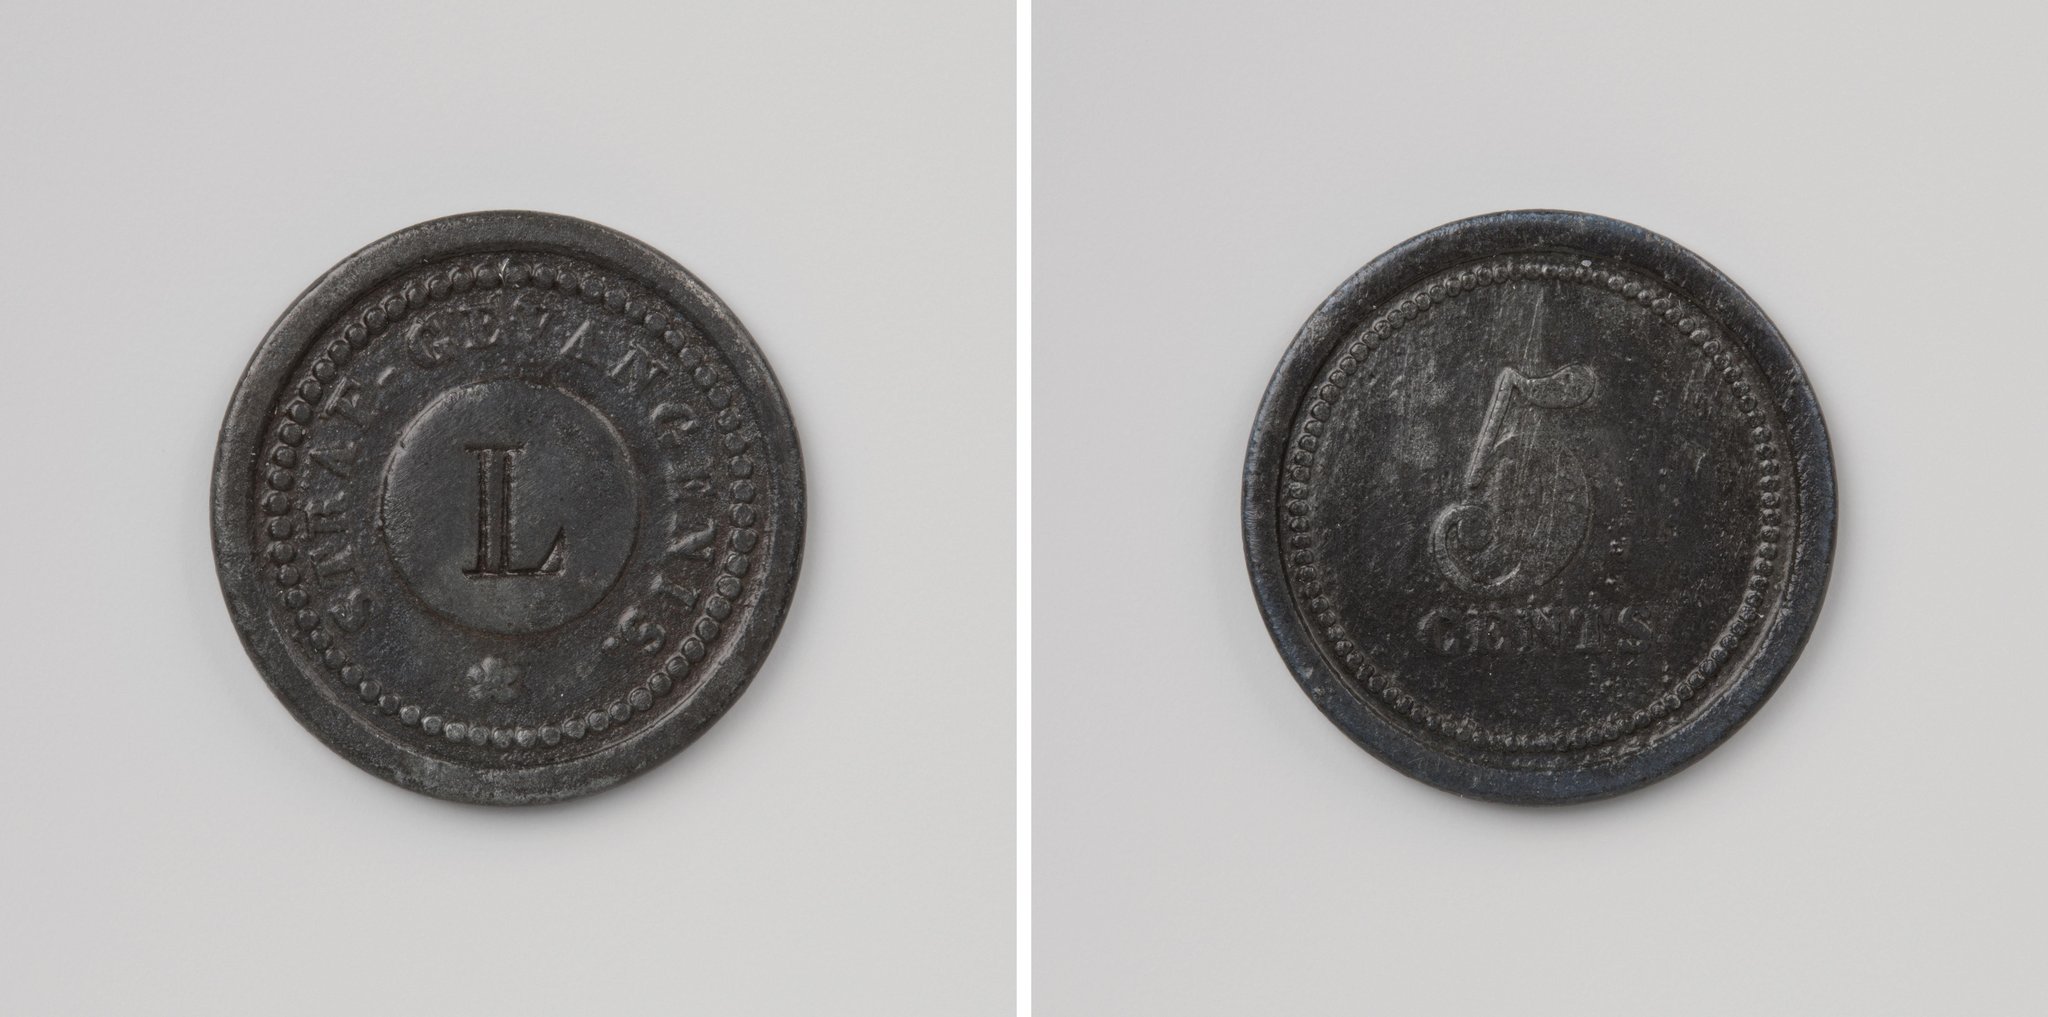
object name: huismunt prison money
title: Militaire strafgevangenis te Leiden, huismunt ter waarde van vijf cents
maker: Anonymous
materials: zinc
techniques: striking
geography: utrecht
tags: leiden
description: Zinken betaalpenning. Voorzijde: letter L binnen omschrift. Keerzijde: waardeaanduiding.